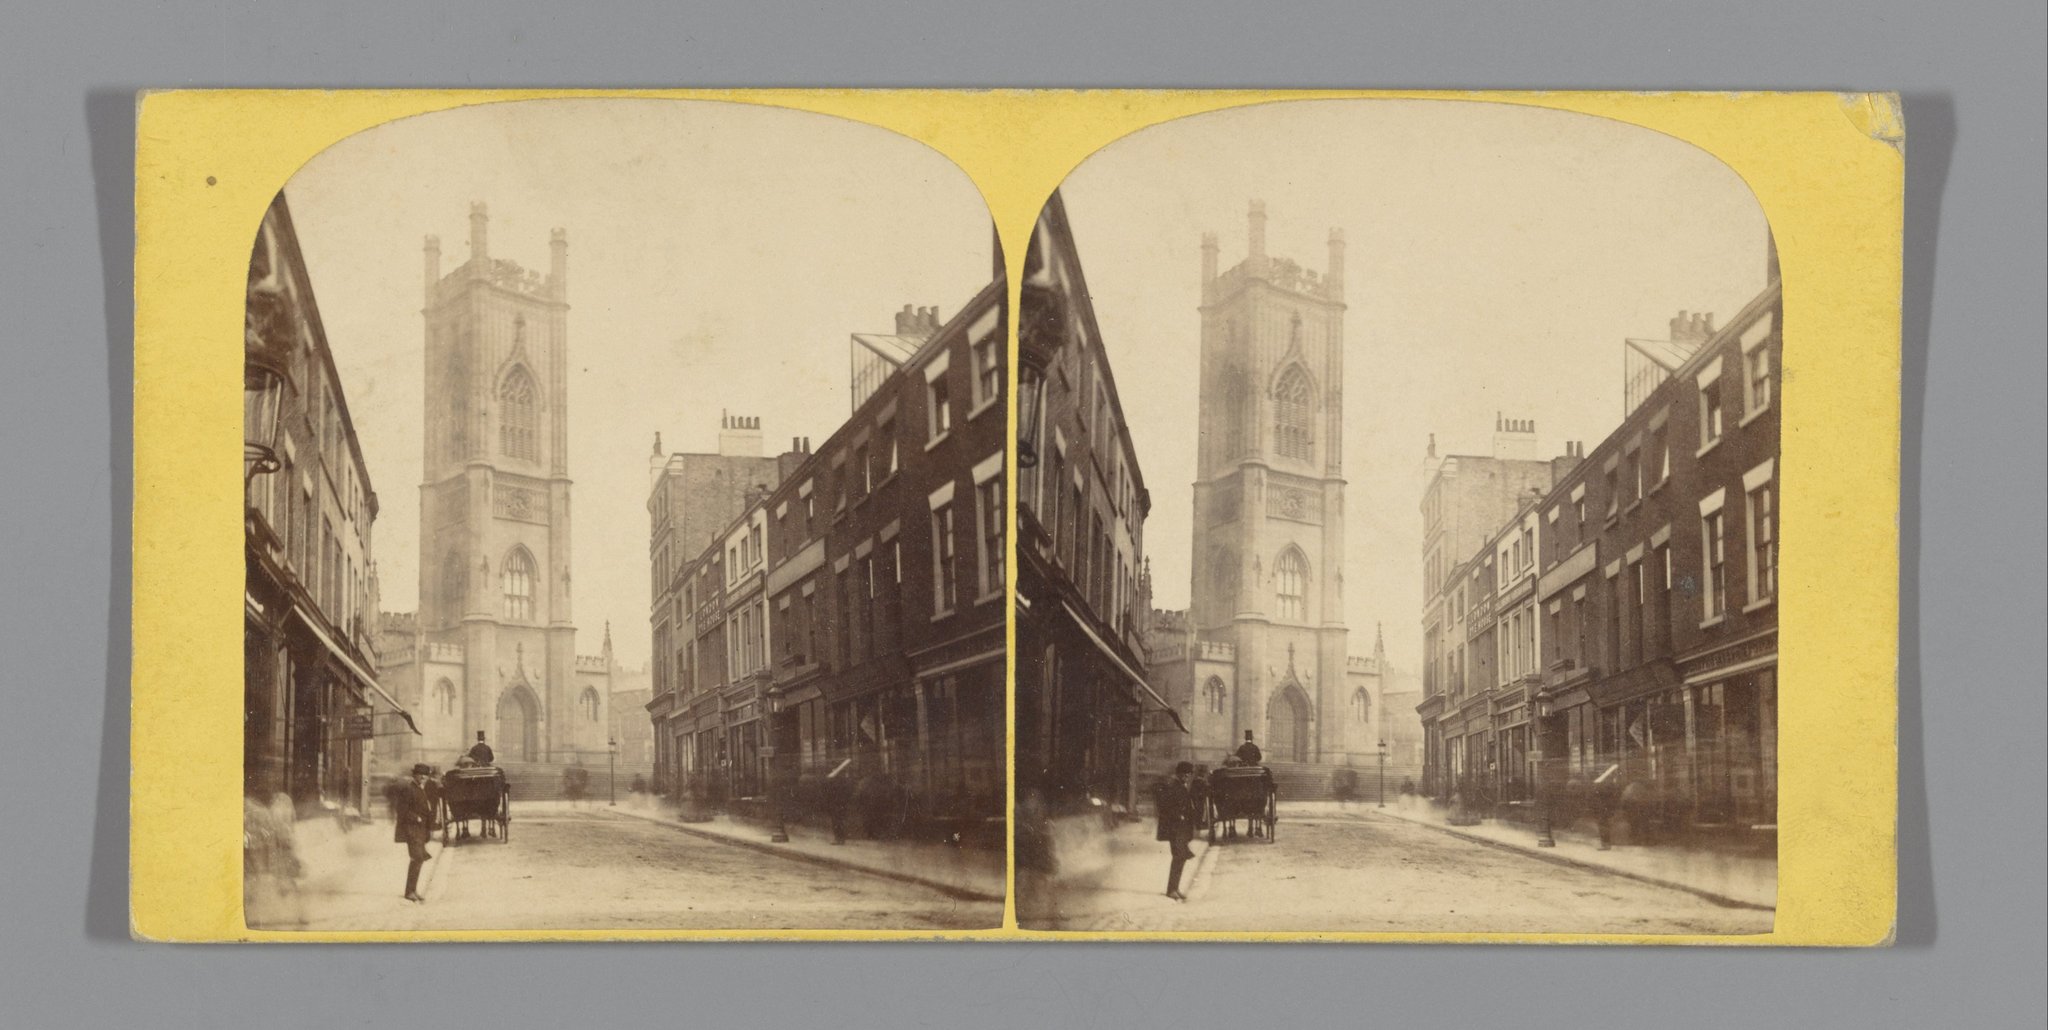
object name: stereograph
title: Gezicht op St Luke's Church te Liverpool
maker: henry sampson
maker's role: fotograaf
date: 1850-1880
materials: cardboard, photographic support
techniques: albumen print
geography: liverpool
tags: church (exterior), street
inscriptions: name: ‘H. Sampson, Photographer, Southport.’